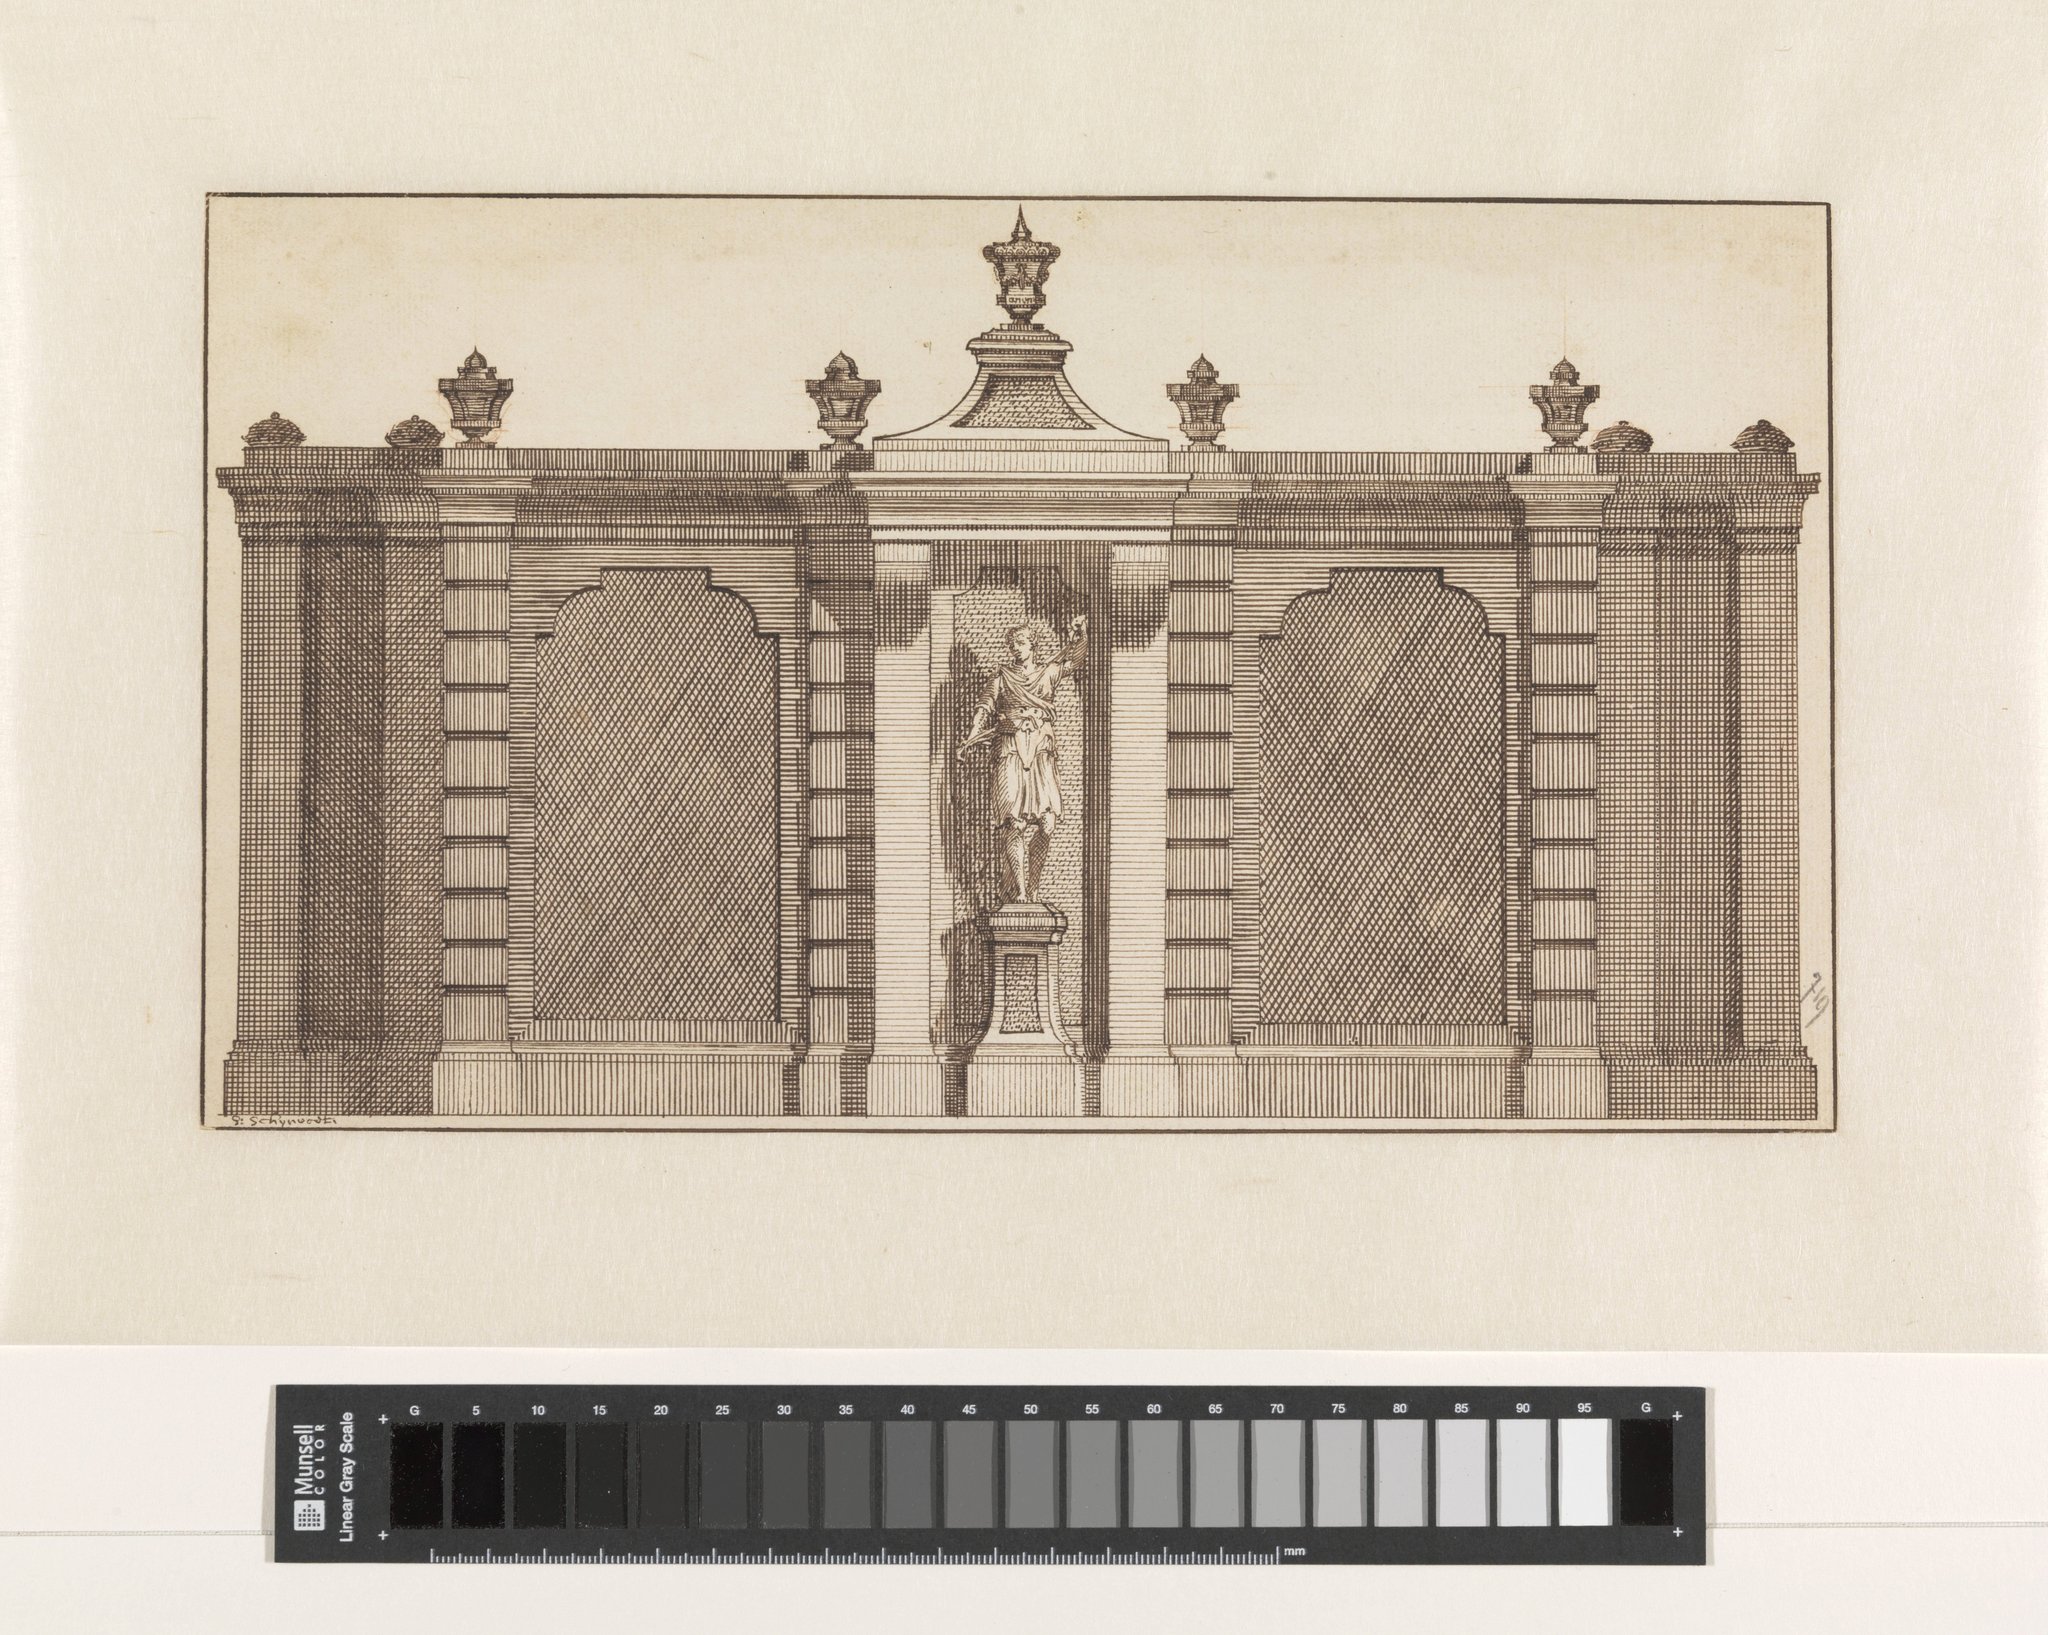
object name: drawing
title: Ontwerp voor een tuinwand met een beeld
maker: simon schijnvoet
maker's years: 1653-1727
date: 1700-1725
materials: ink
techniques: pen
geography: amsterdam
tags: garden ornaments, statues, sculptures in garden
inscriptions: signature: ‘S: Schijnvoet.’